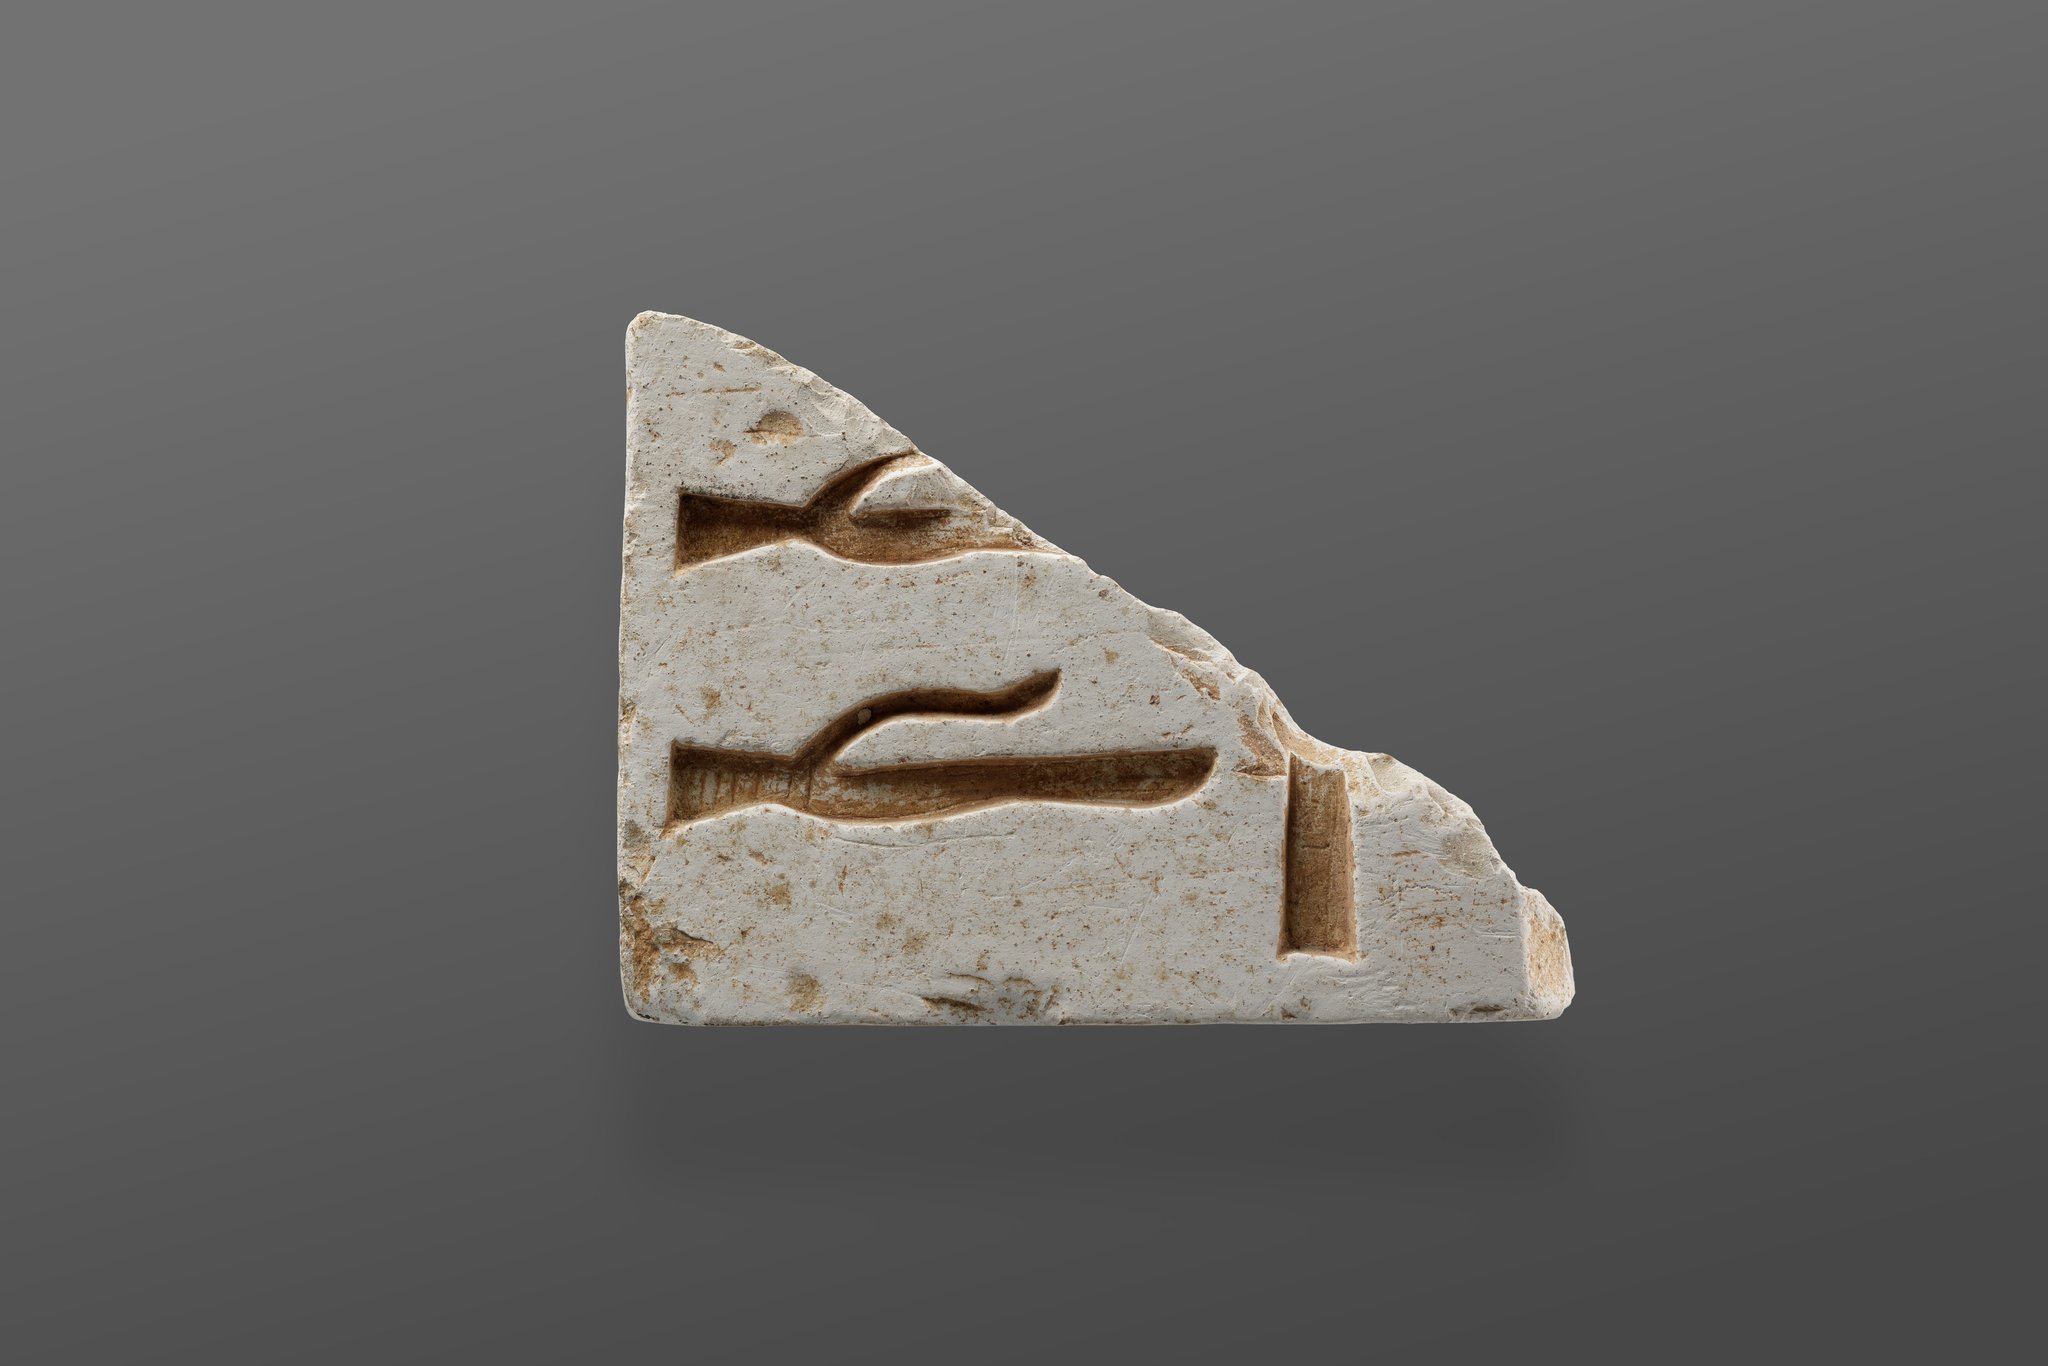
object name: relief fragment 47, tomb of mereri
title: Relief fragment possibly from the tomb of Mereri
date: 2100-2090 BCE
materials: stone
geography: egypt